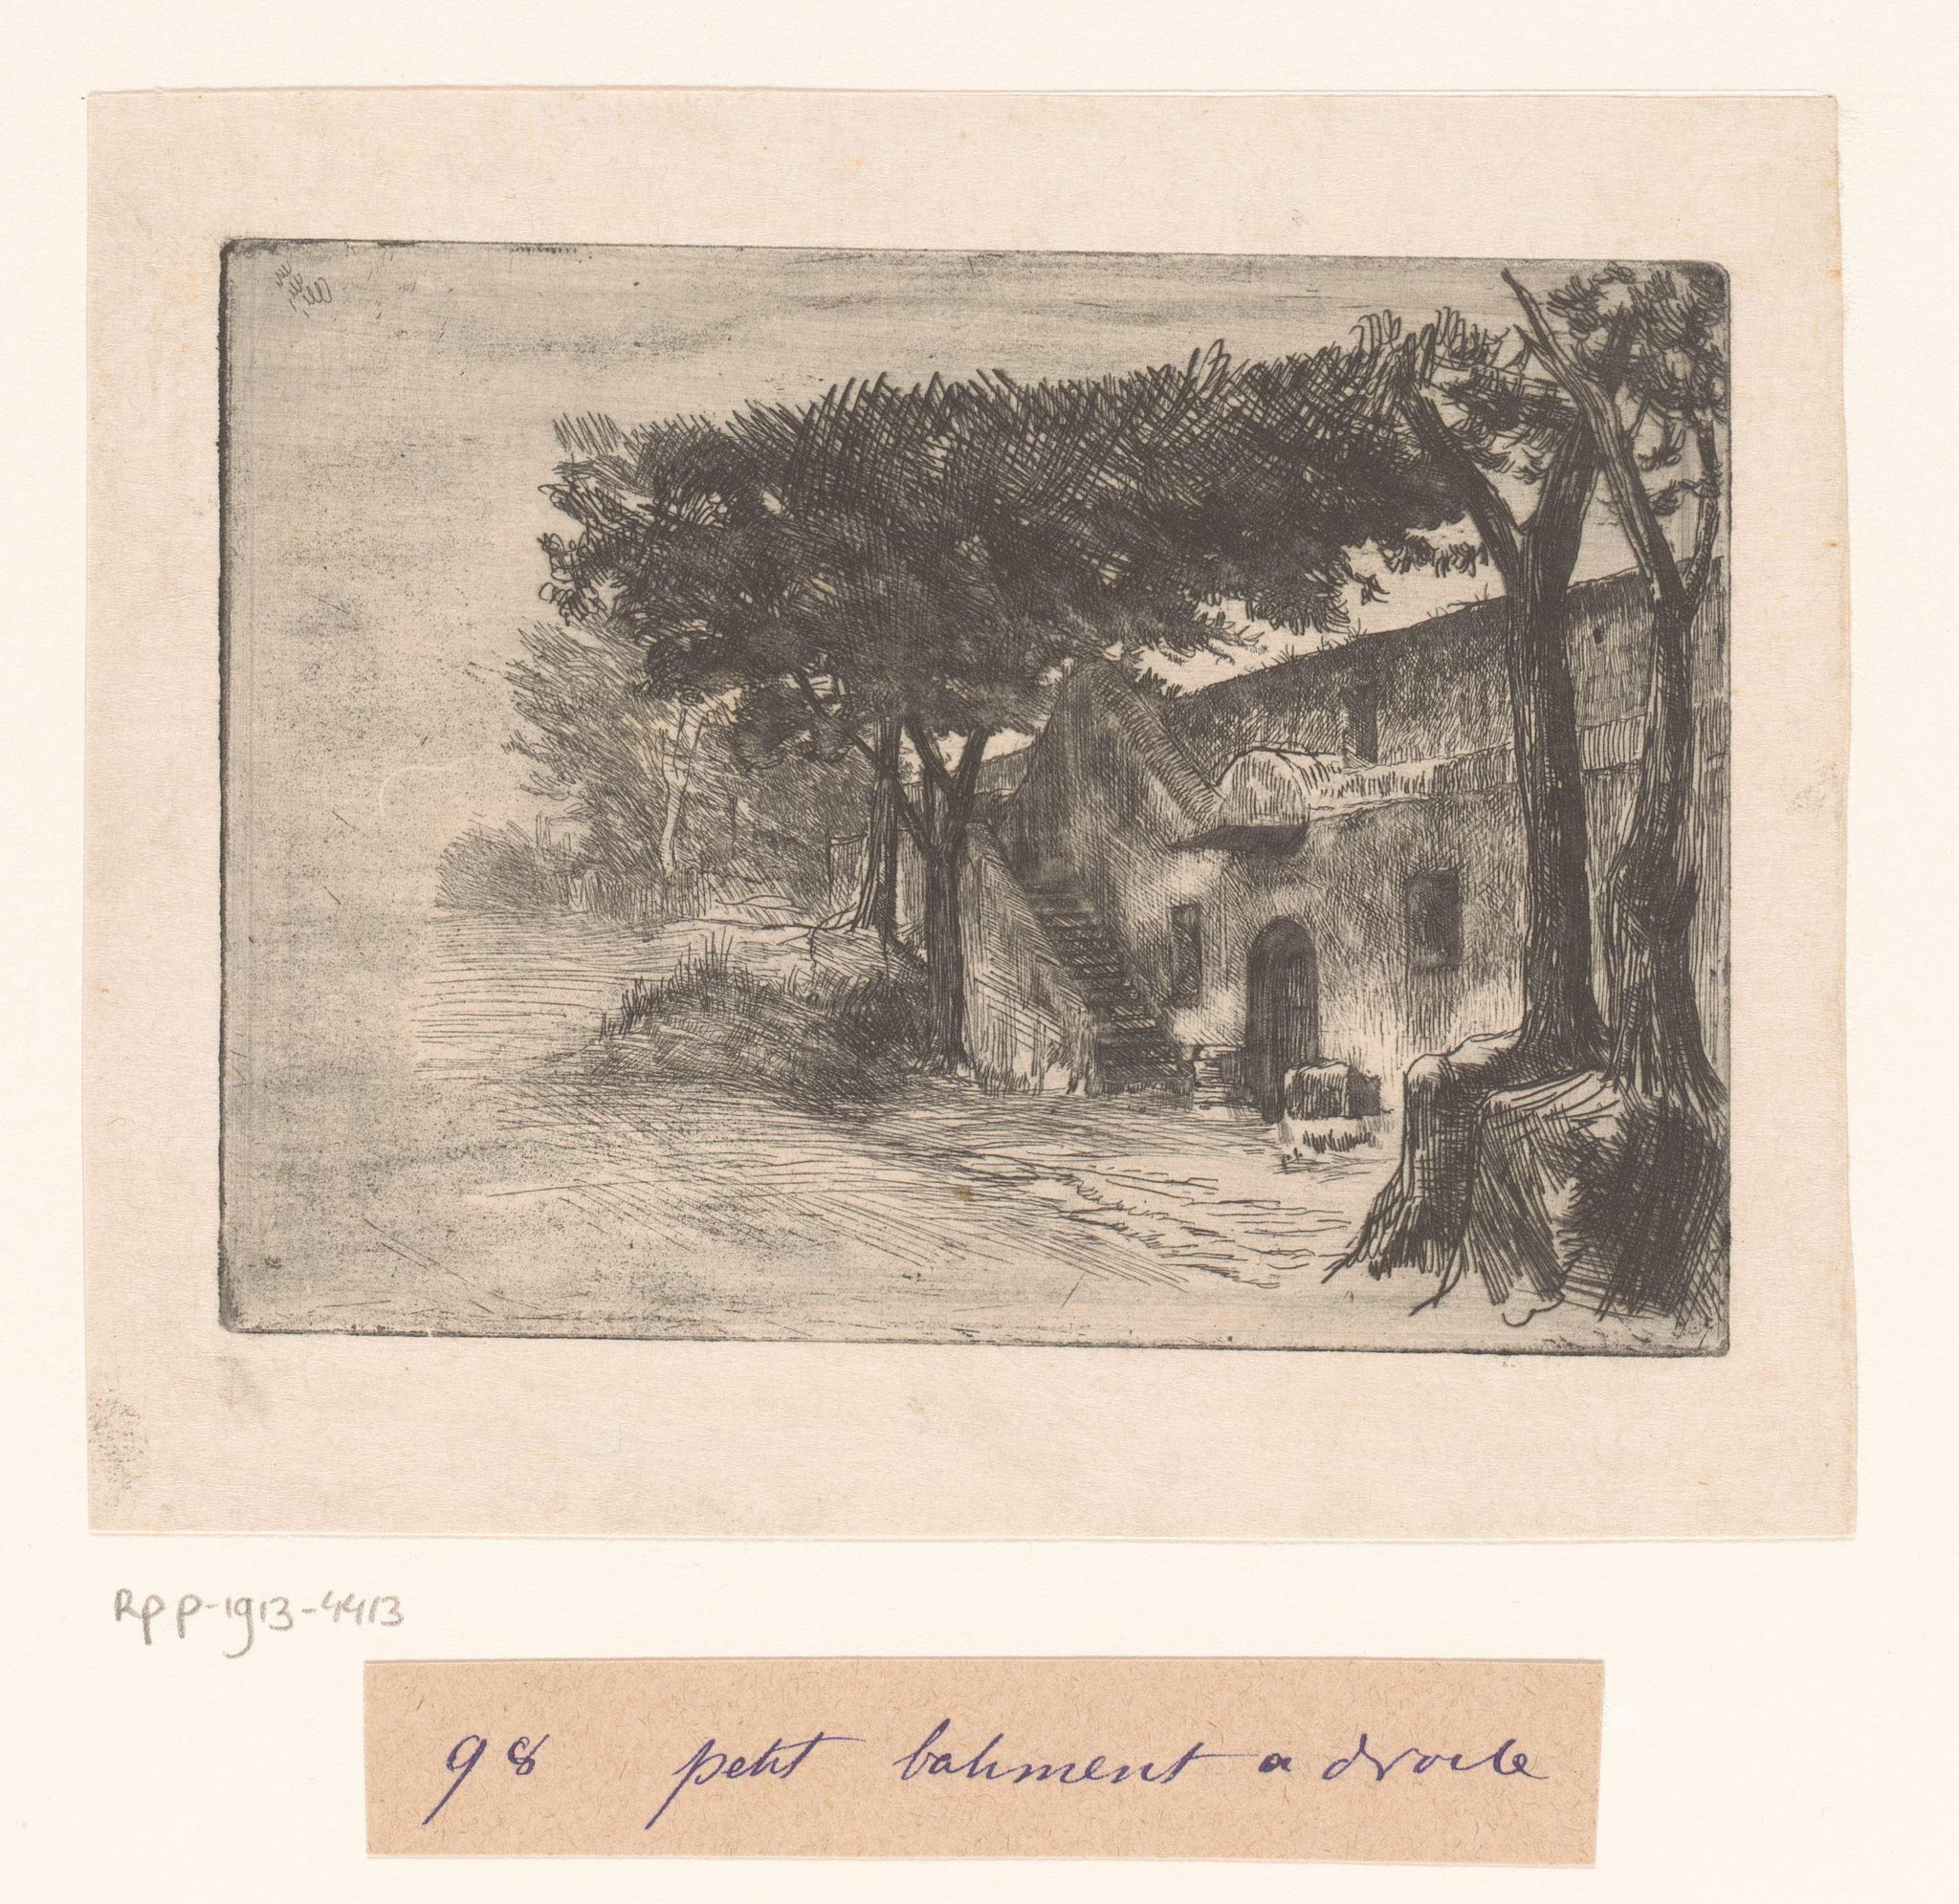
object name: print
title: Gebouw met trap langs de gevel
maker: adrien de witte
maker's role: print maker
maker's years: 1850-1935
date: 1860-1913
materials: paper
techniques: etching, intaglio, retroussage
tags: trees, housing, staircase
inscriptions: collector's mark: Lugt 2228